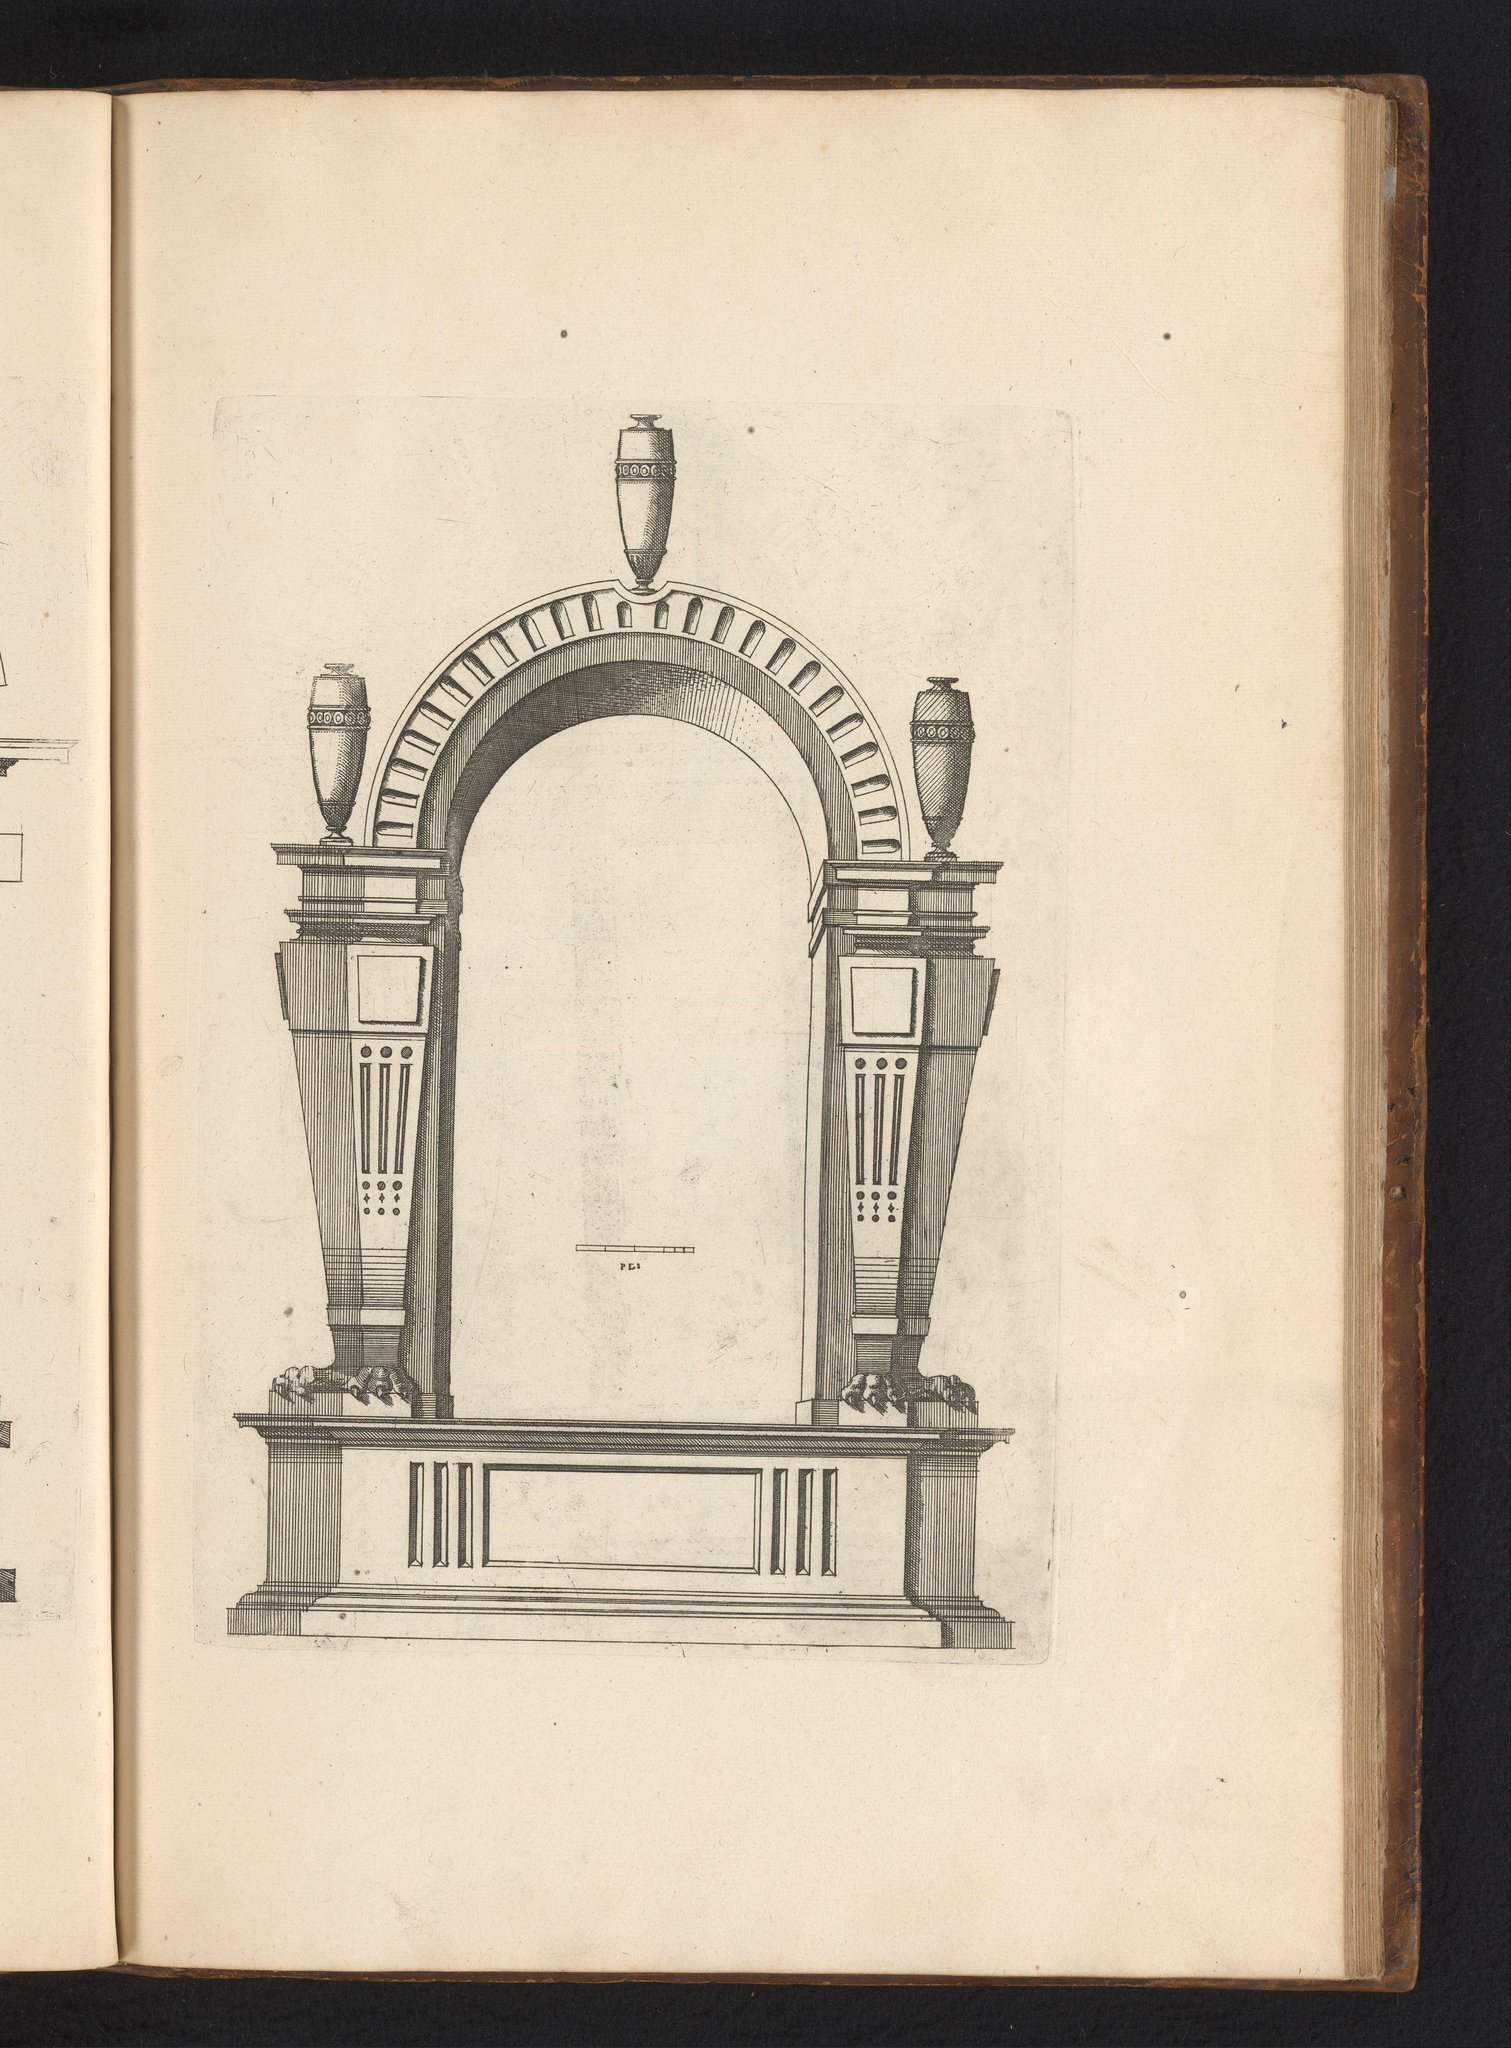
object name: ornament print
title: Dakraam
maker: jacques androuet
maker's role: draughtsman, print maker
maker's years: 1515-1584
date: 1561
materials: paper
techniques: etching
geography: paris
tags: window, architectural representations in general, arch, archivolt ~ architecture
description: Dakraam met drie vazen. Onderdeel van 'Seconde livre d'architectvre' (1561): 64 etsen met geornamenteerde architectuuronderdelen.